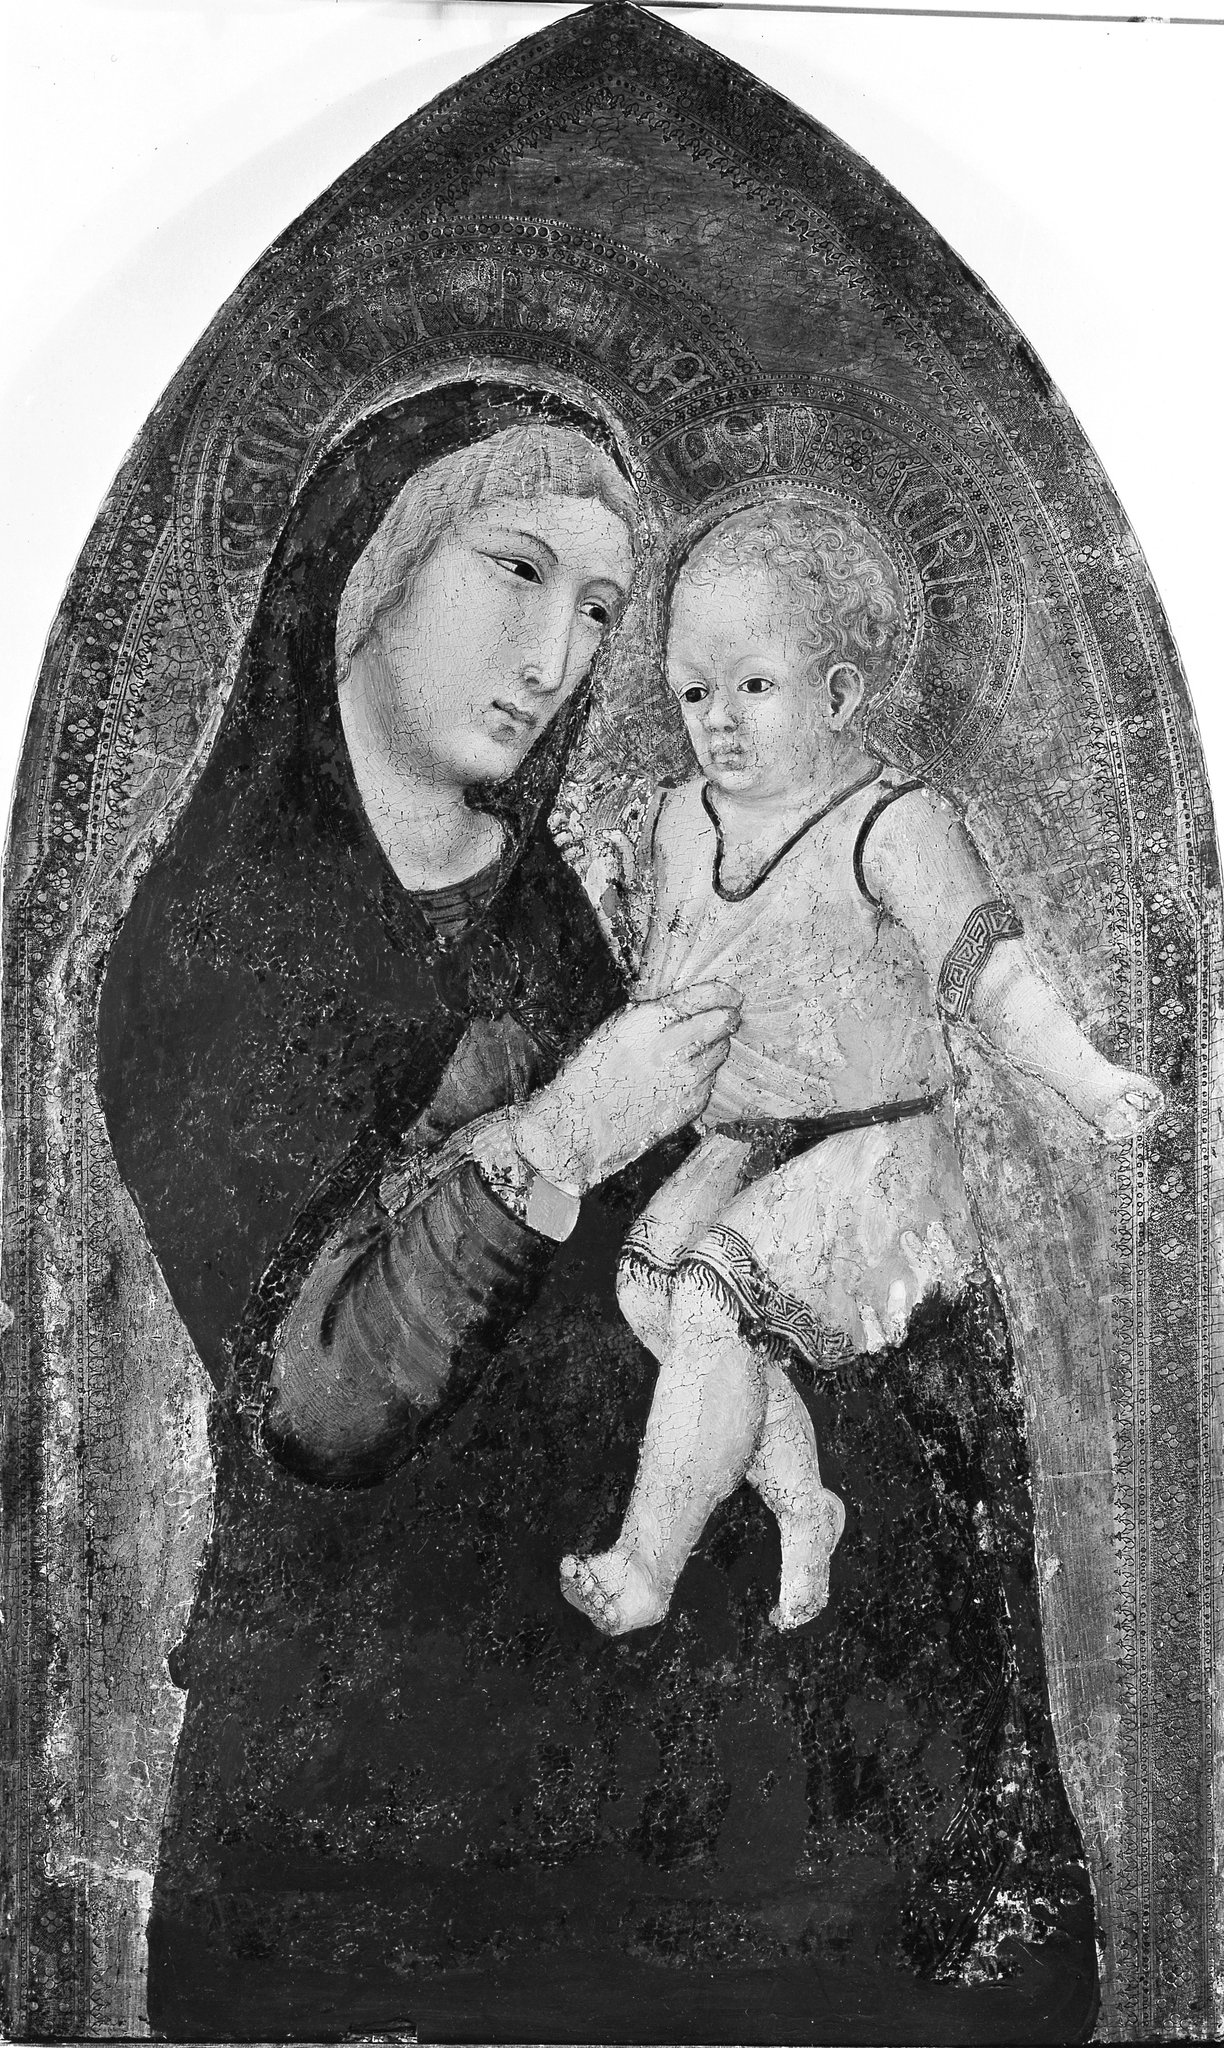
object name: painting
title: Madonna and Child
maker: ambrogio lorenzetti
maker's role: artist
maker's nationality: italian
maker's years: 1319-1347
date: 1319-1347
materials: gold leaf, paint, wood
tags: madonna and child